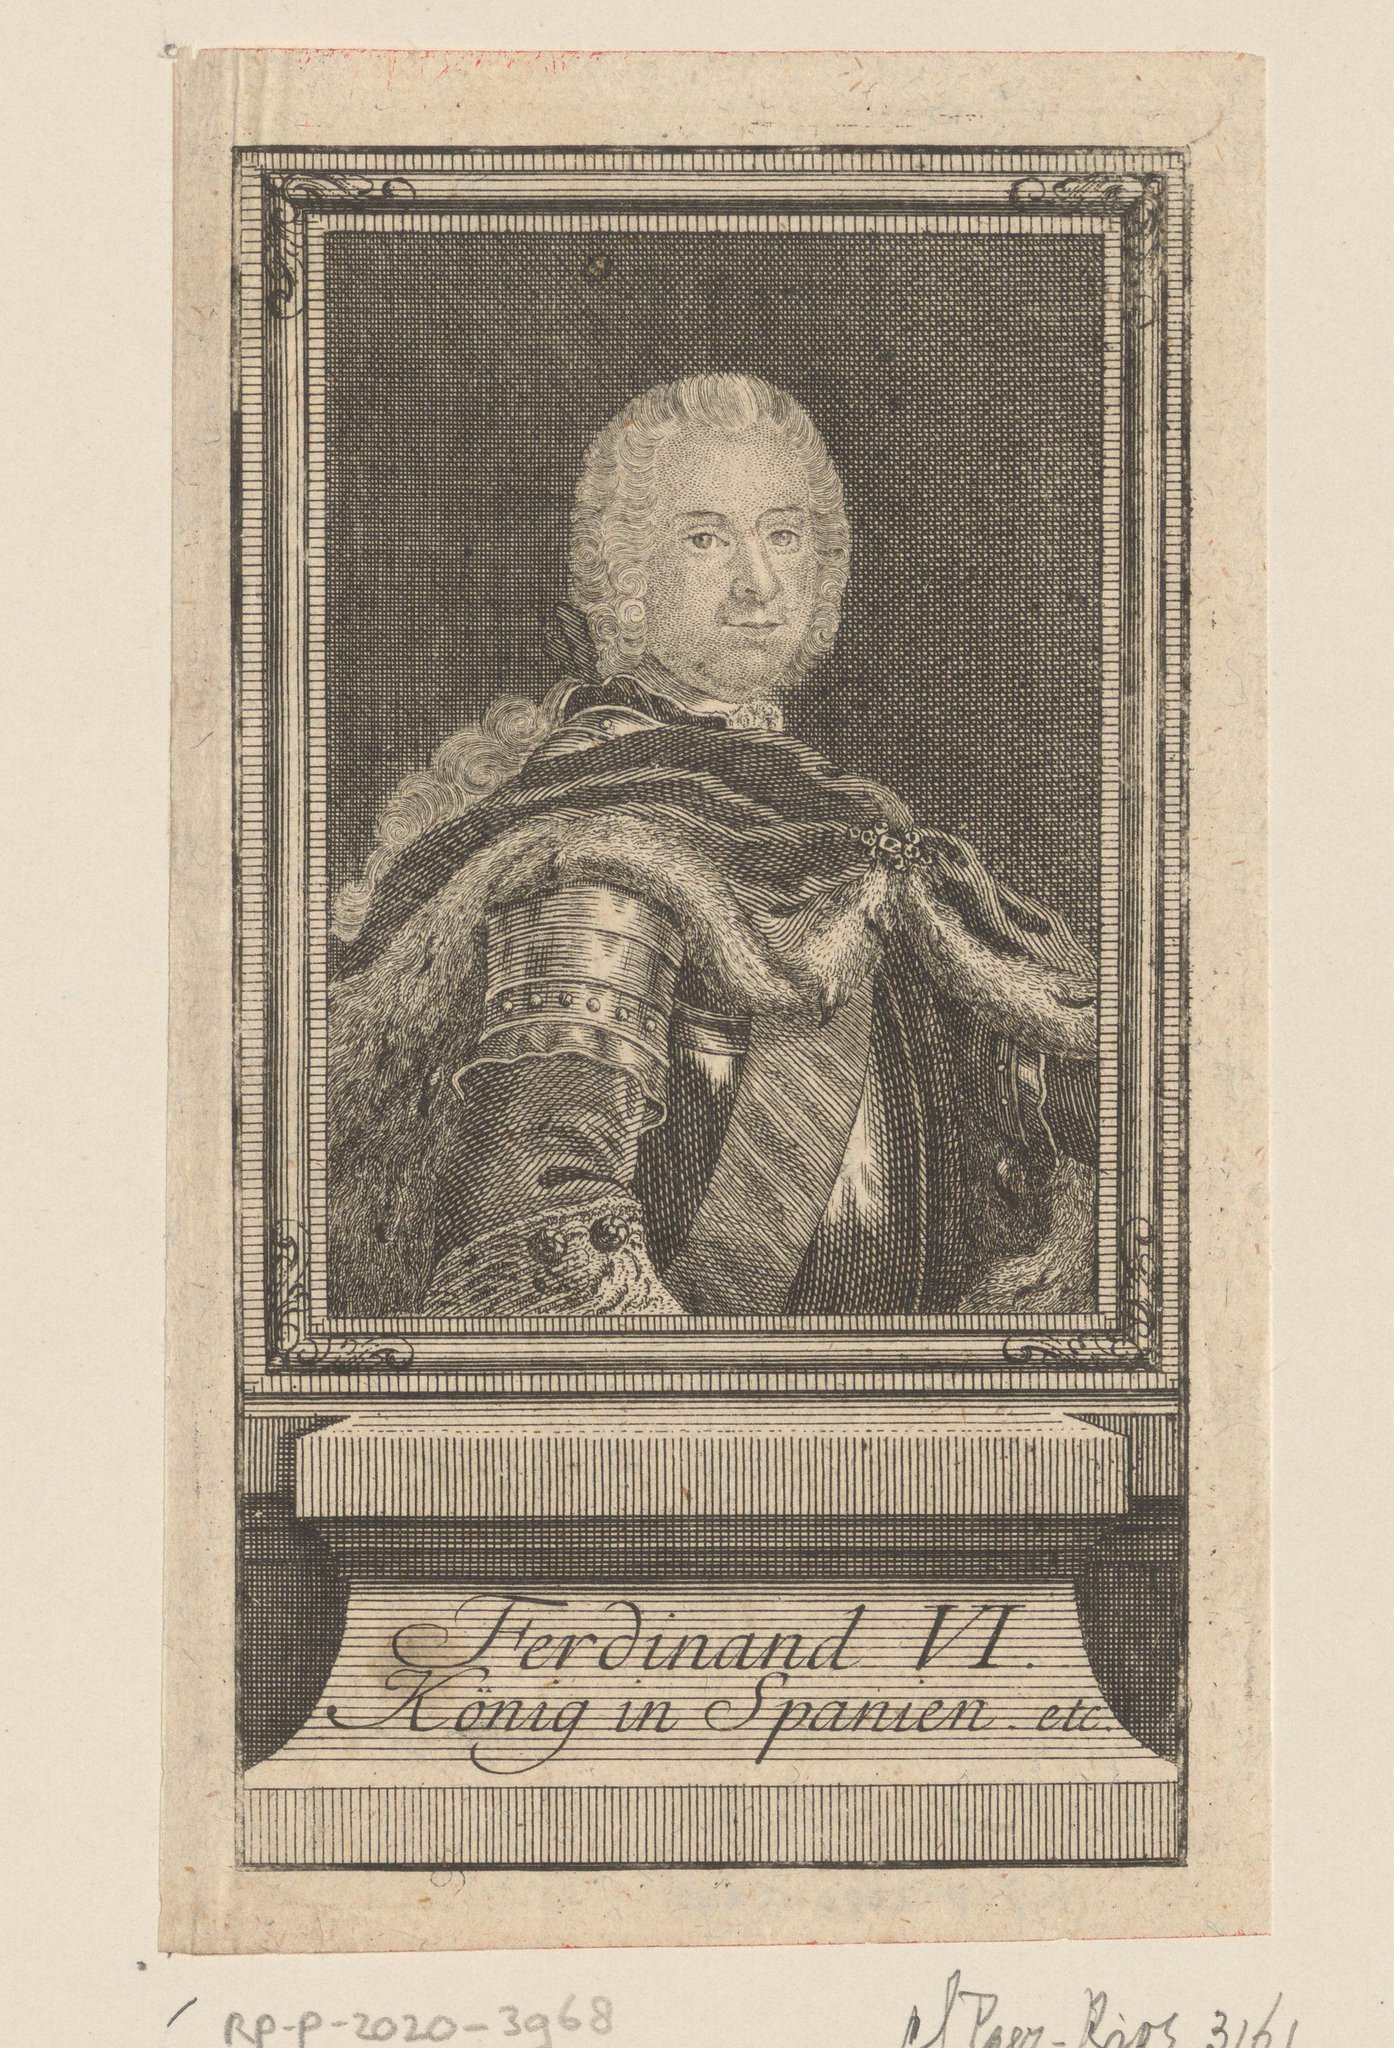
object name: print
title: Portret van Ferdinand VI van Spanje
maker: johann christoph sysang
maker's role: print maker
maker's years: 1703-1757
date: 1751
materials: paper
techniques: engraving, etching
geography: germany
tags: historical persons, king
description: Prent waarschijnlijk uit: Europäische staats-Cantzley, vol. 99, 1751.